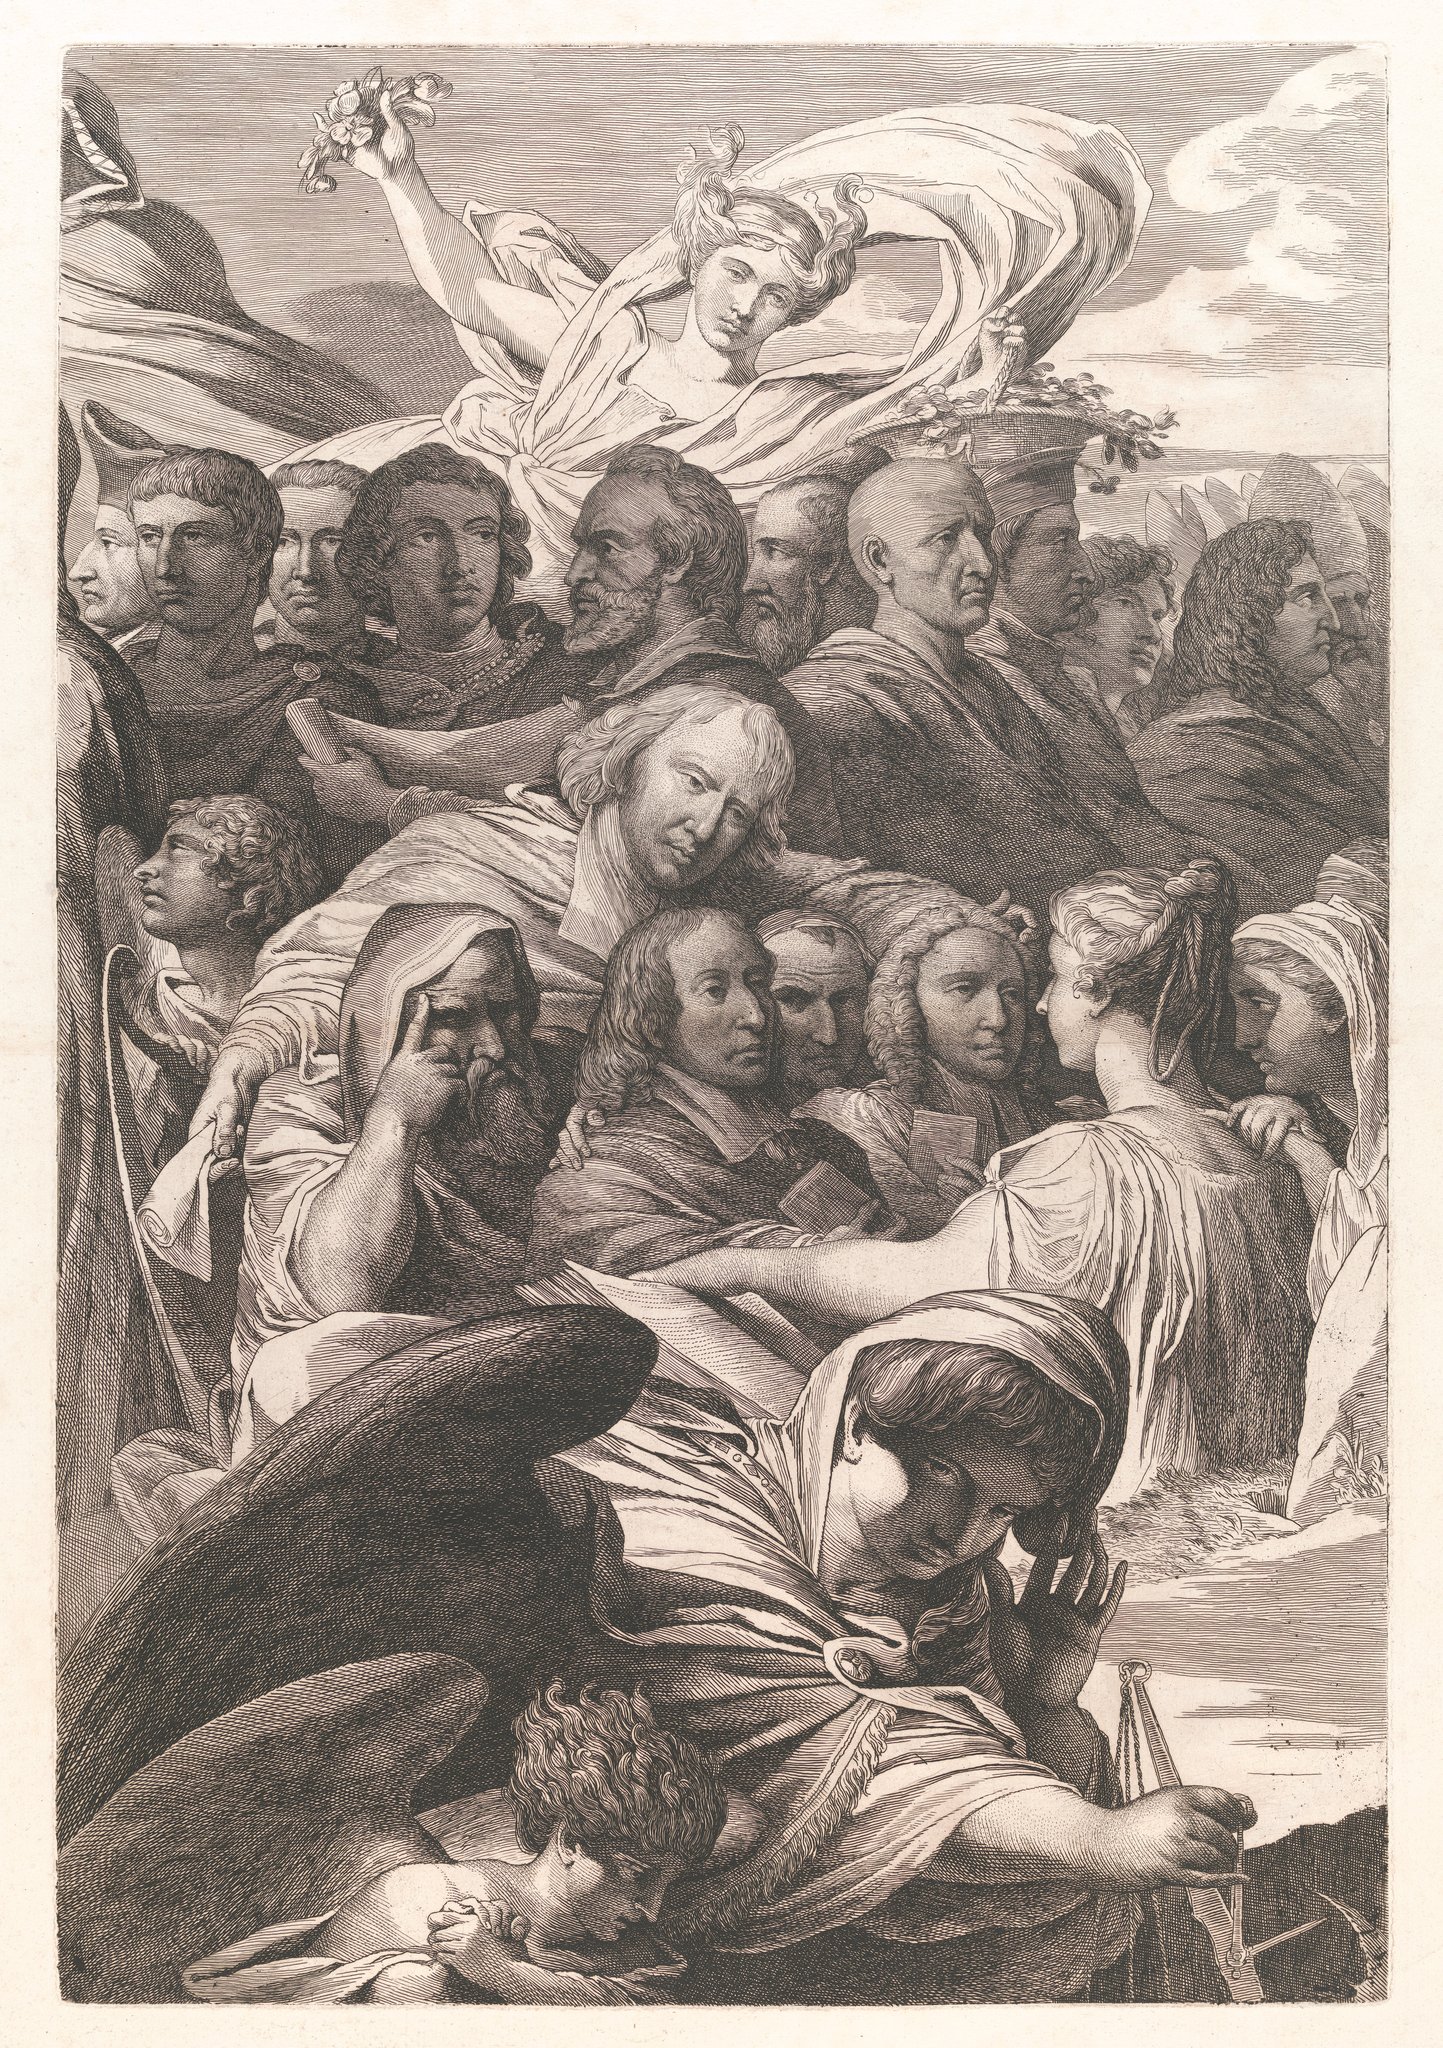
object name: print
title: Divine Justice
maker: james barry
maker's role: artist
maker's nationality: irish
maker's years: 1741-1806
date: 1808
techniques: engraving, etching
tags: alexander the great,louis xiv,angels,law